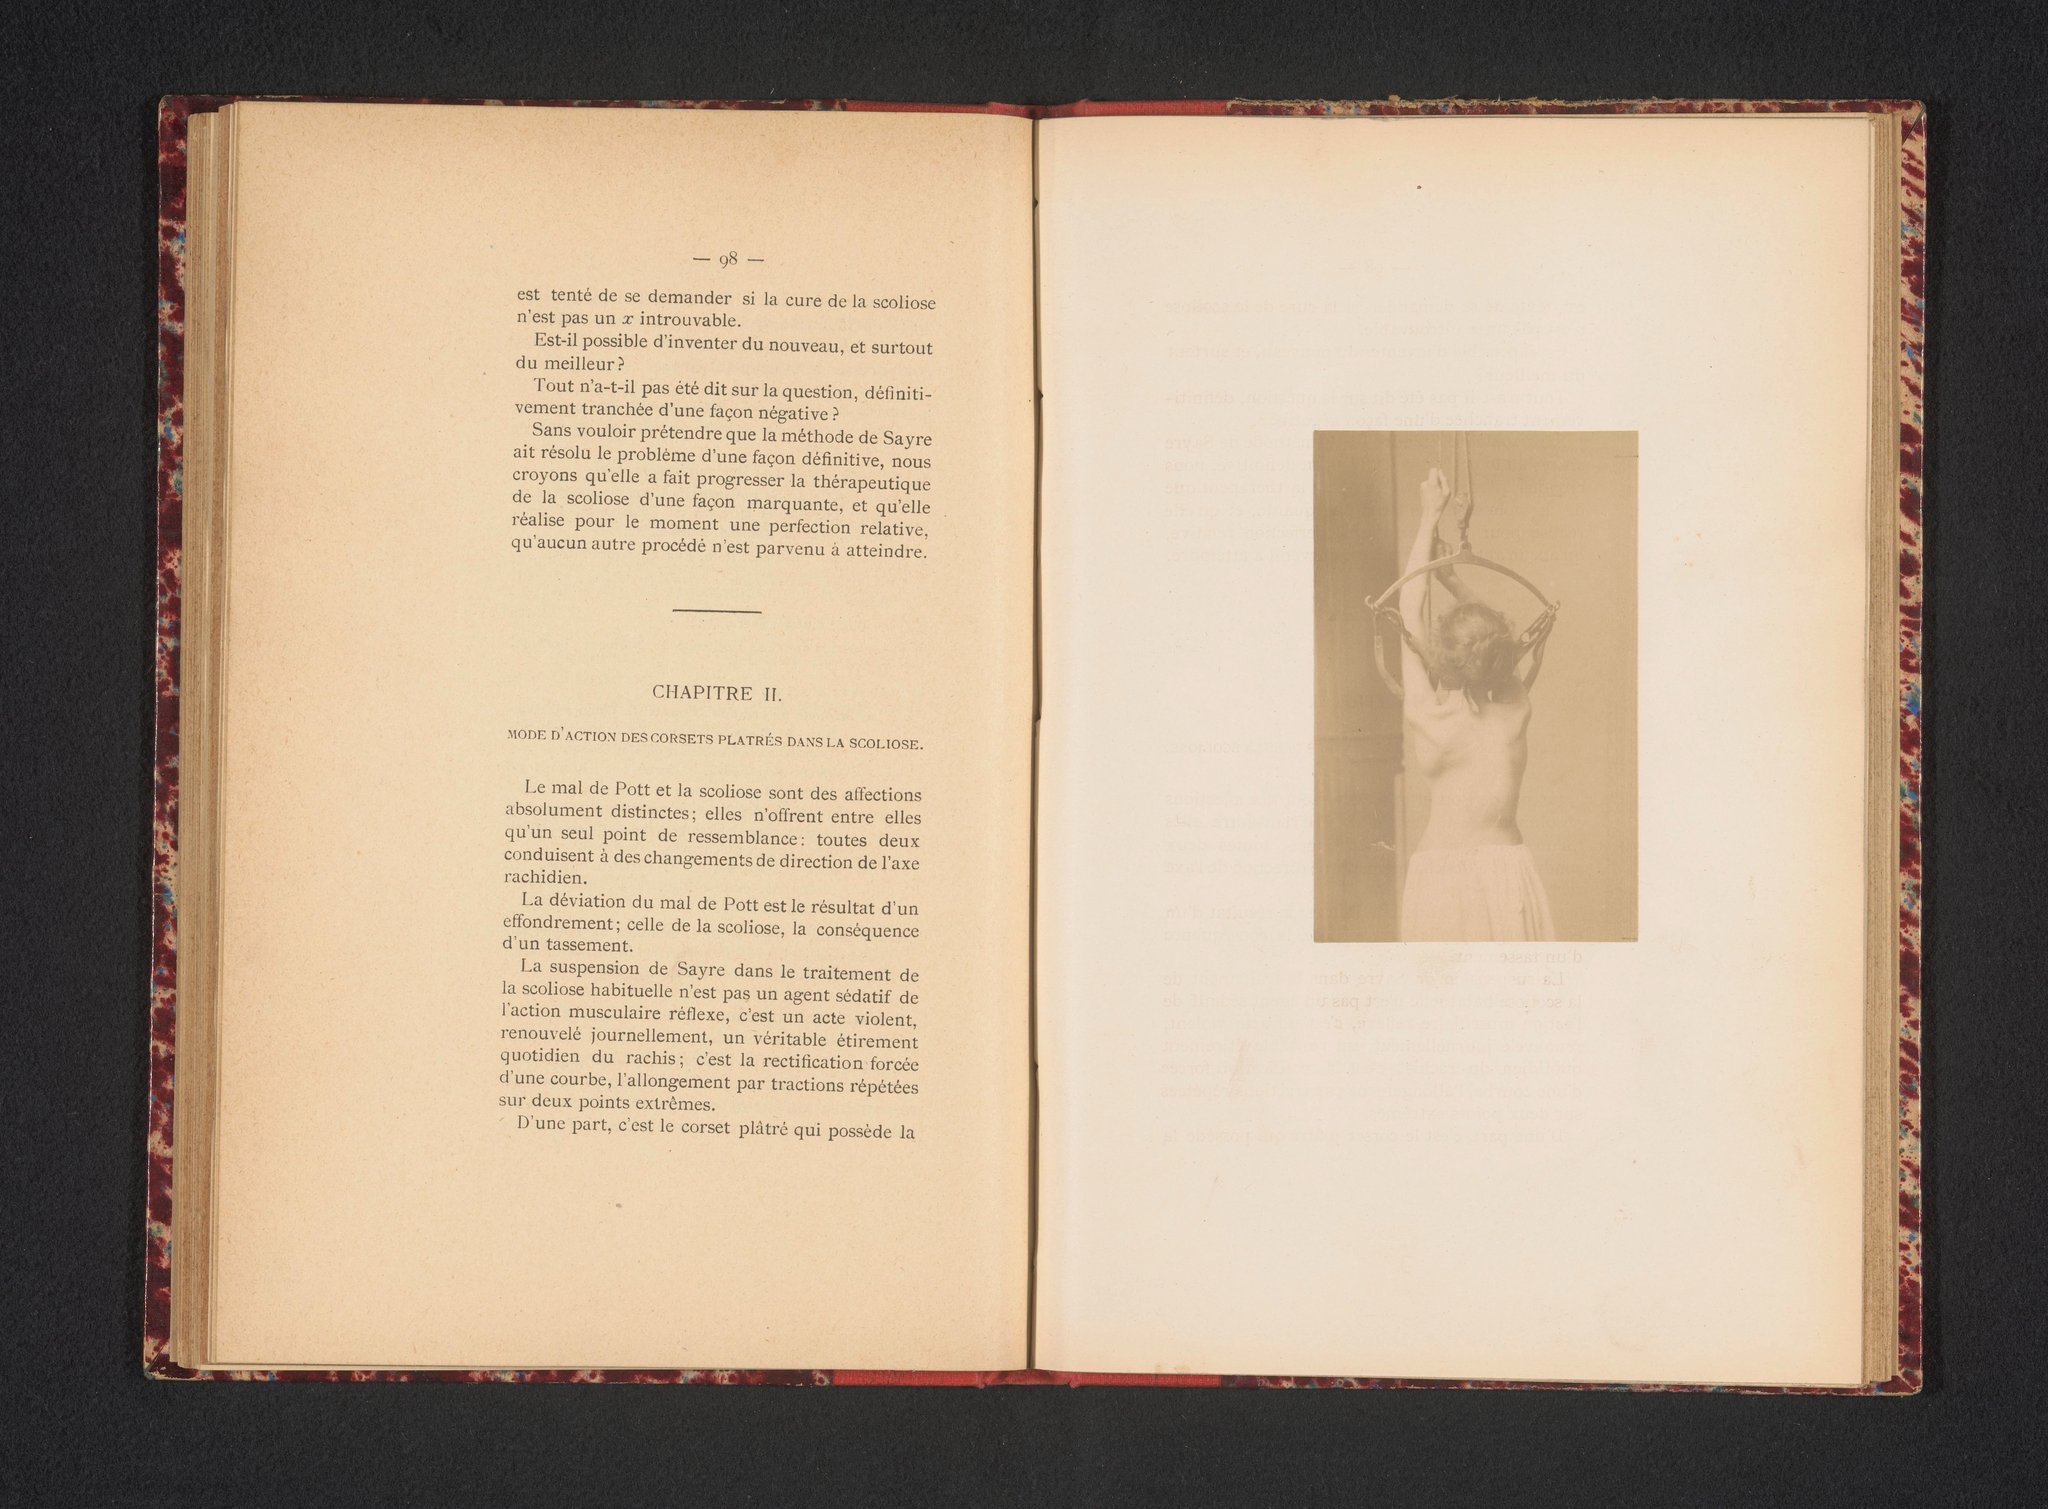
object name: page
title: Meisje ondergaat een behandeling voor problemen met haar ruggengraat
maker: Anonymous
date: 1884-1889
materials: photographic support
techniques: albumen print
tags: girl (child between toddler and youth), medical examination, medical treatment